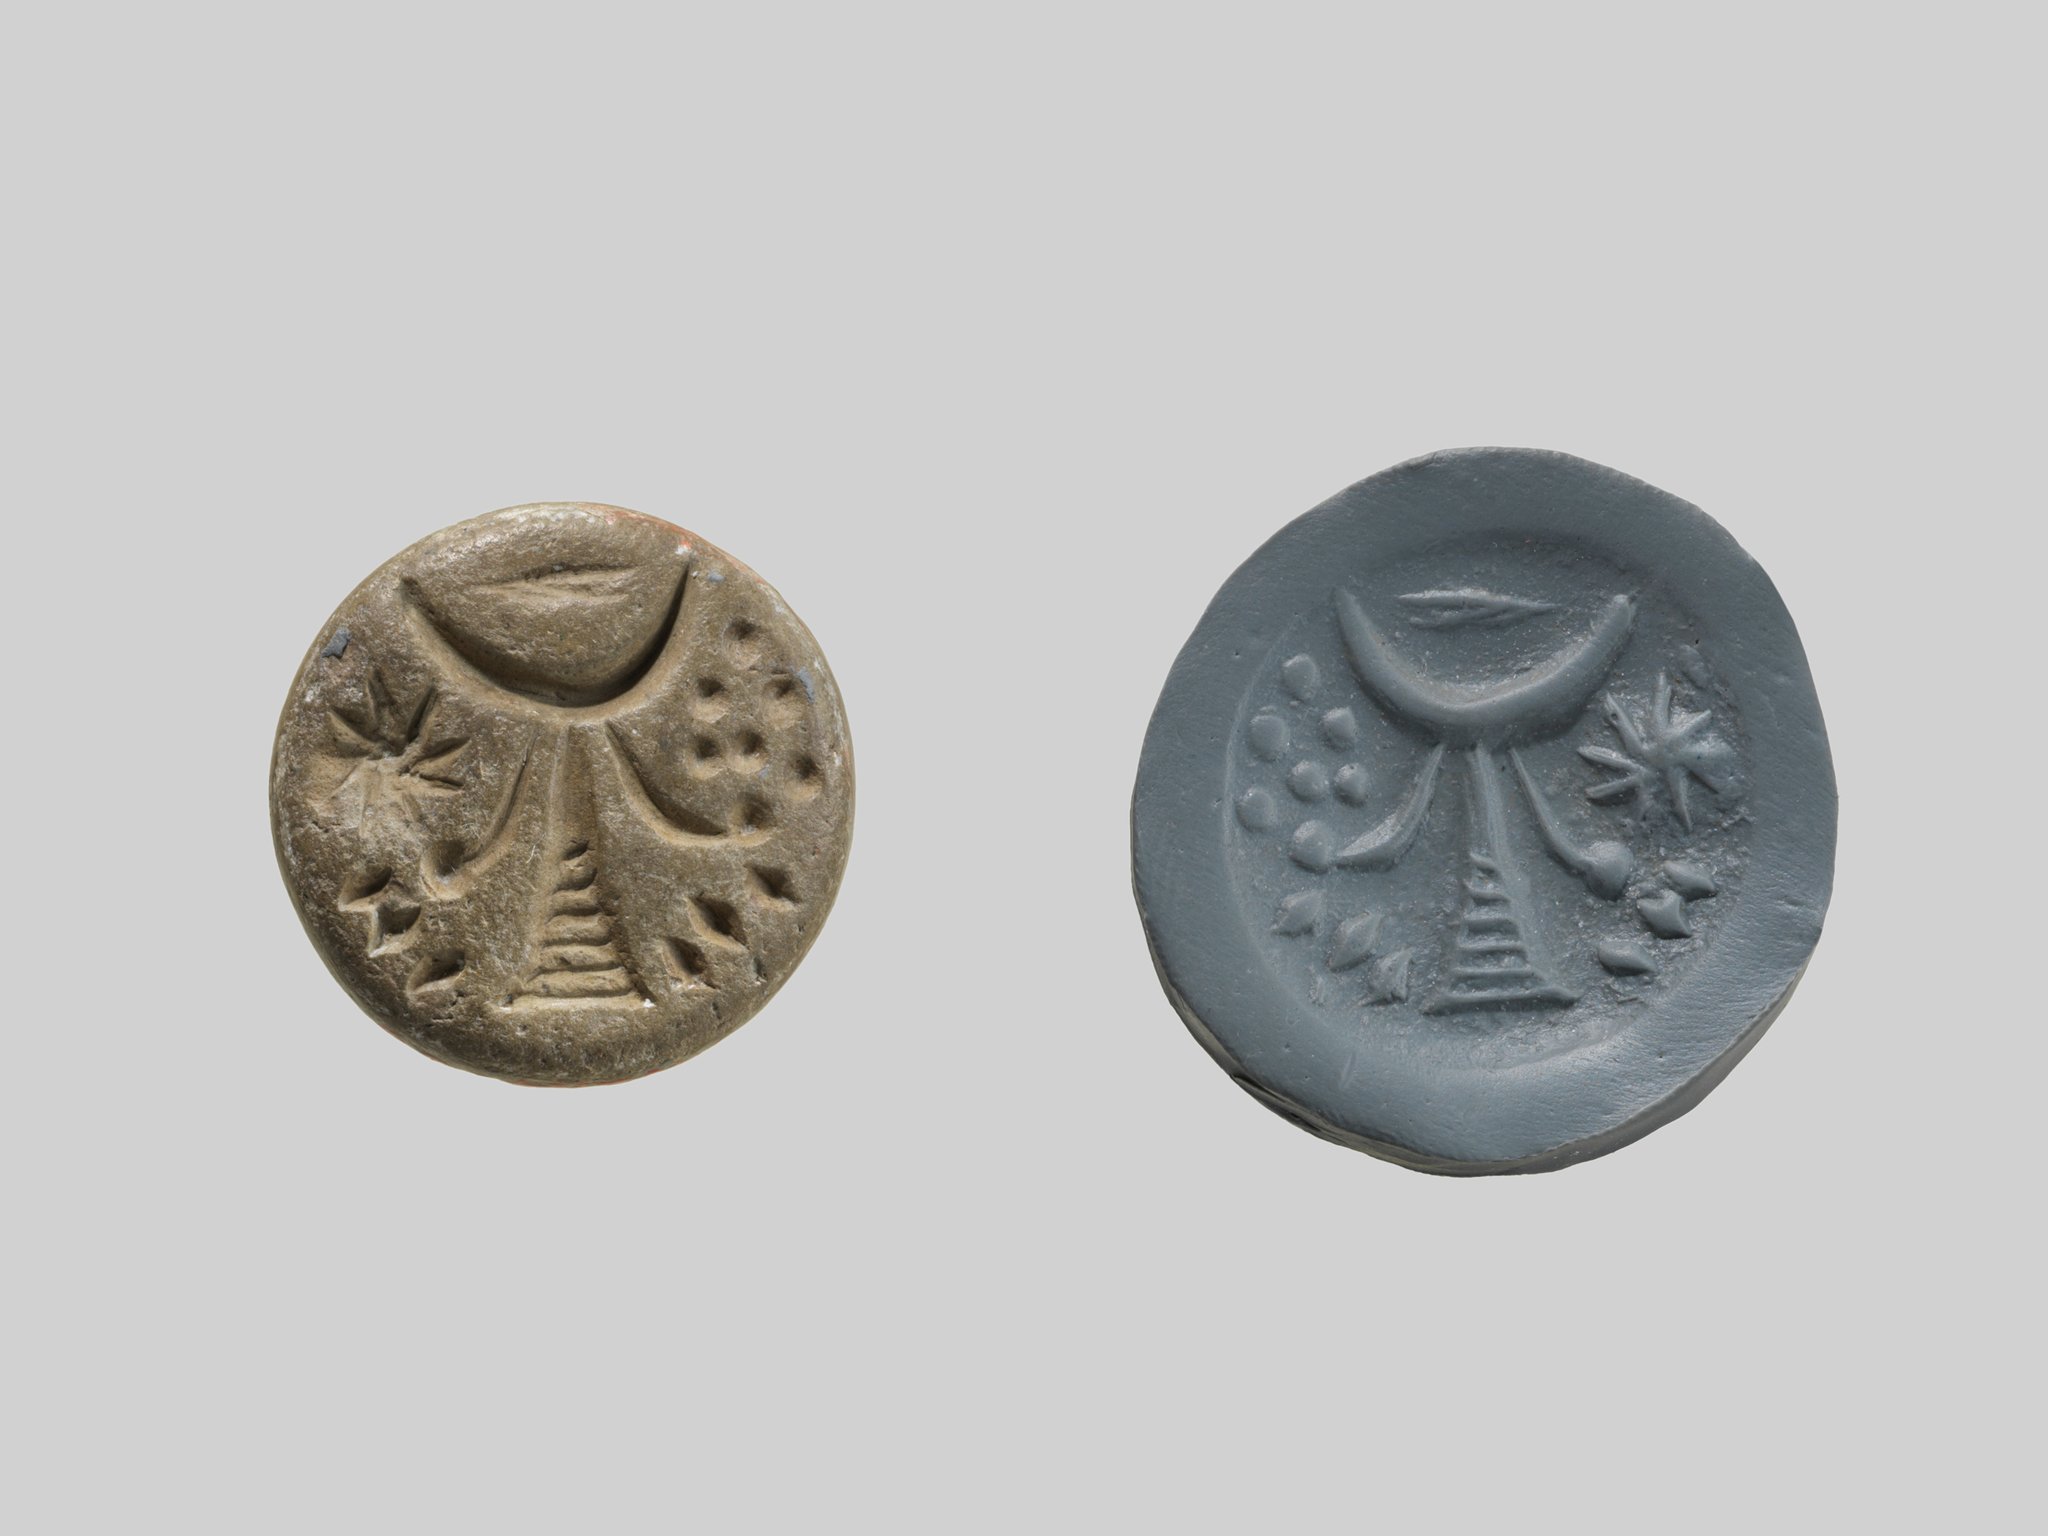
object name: stamp seal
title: Stamp seal (button-shaped) with divine symbols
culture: assyrian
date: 734-601 BCE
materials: ceramic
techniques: glazing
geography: mesopotamia